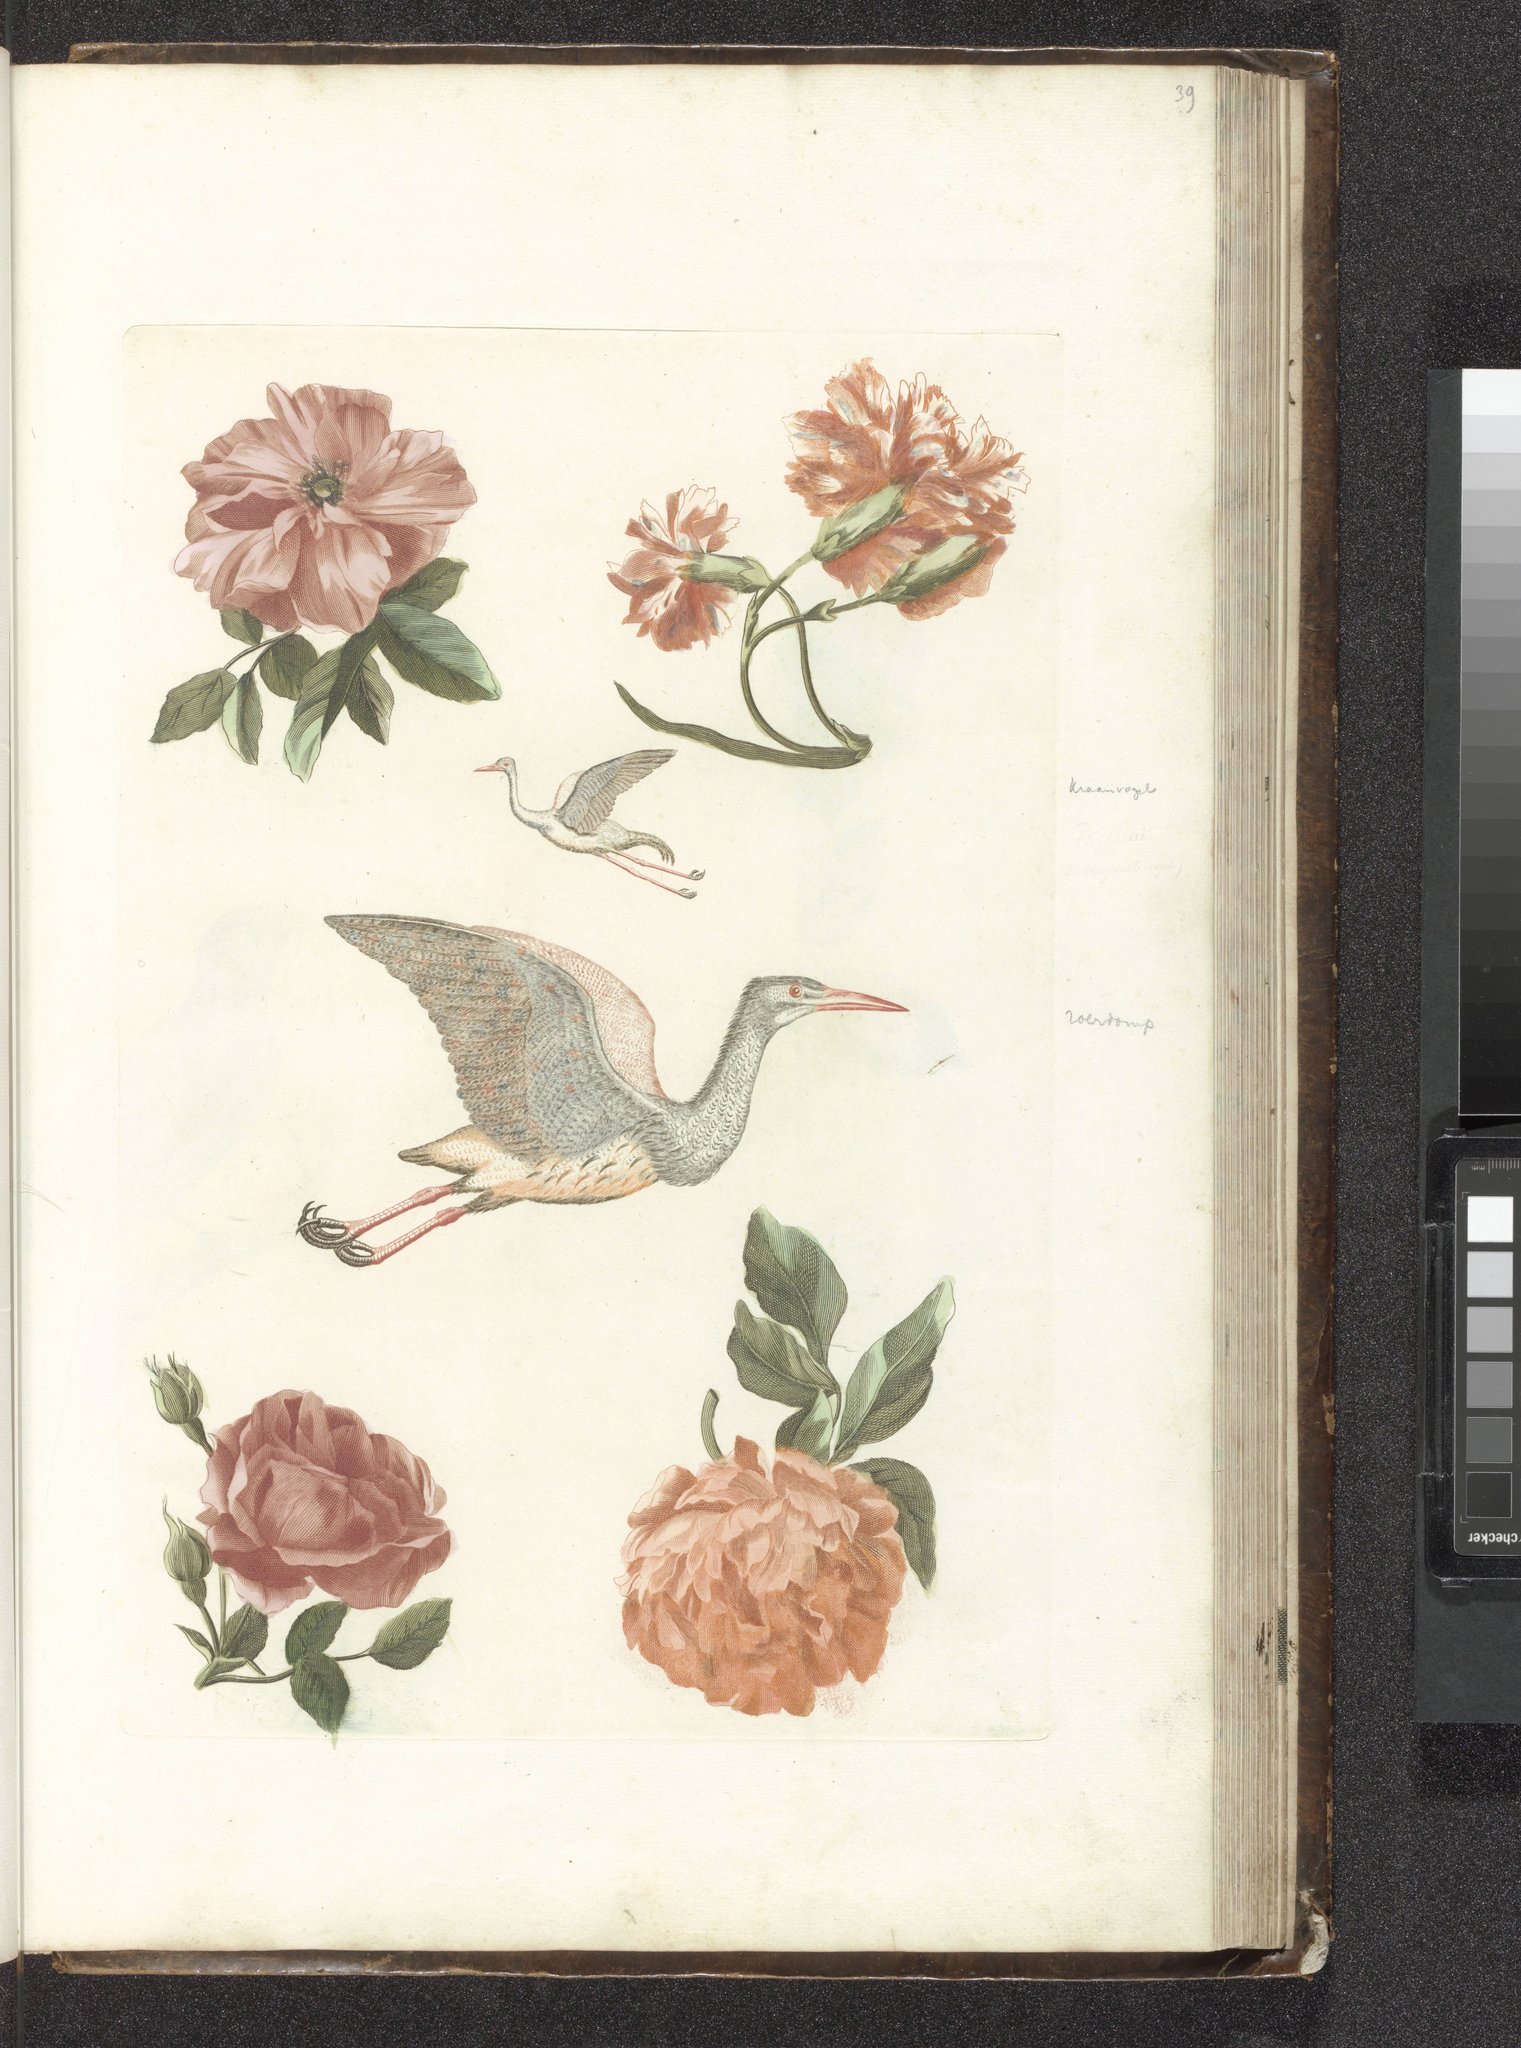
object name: album leaf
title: Bloemen, kraanvogel en roerdomp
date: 1688-1698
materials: paper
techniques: engraving, etching, hand coloring, lithography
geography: netherlands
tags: shore-birds and wading-birds: crane, flowers: rose, flowers: carnation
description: Vier verschillende bloemen, waaronder een roos en een anjer. In het midden een vliegende kraanvogel (boven) en een vliegende roerdomp (onder). Deze prent maakt deel uit van een album.